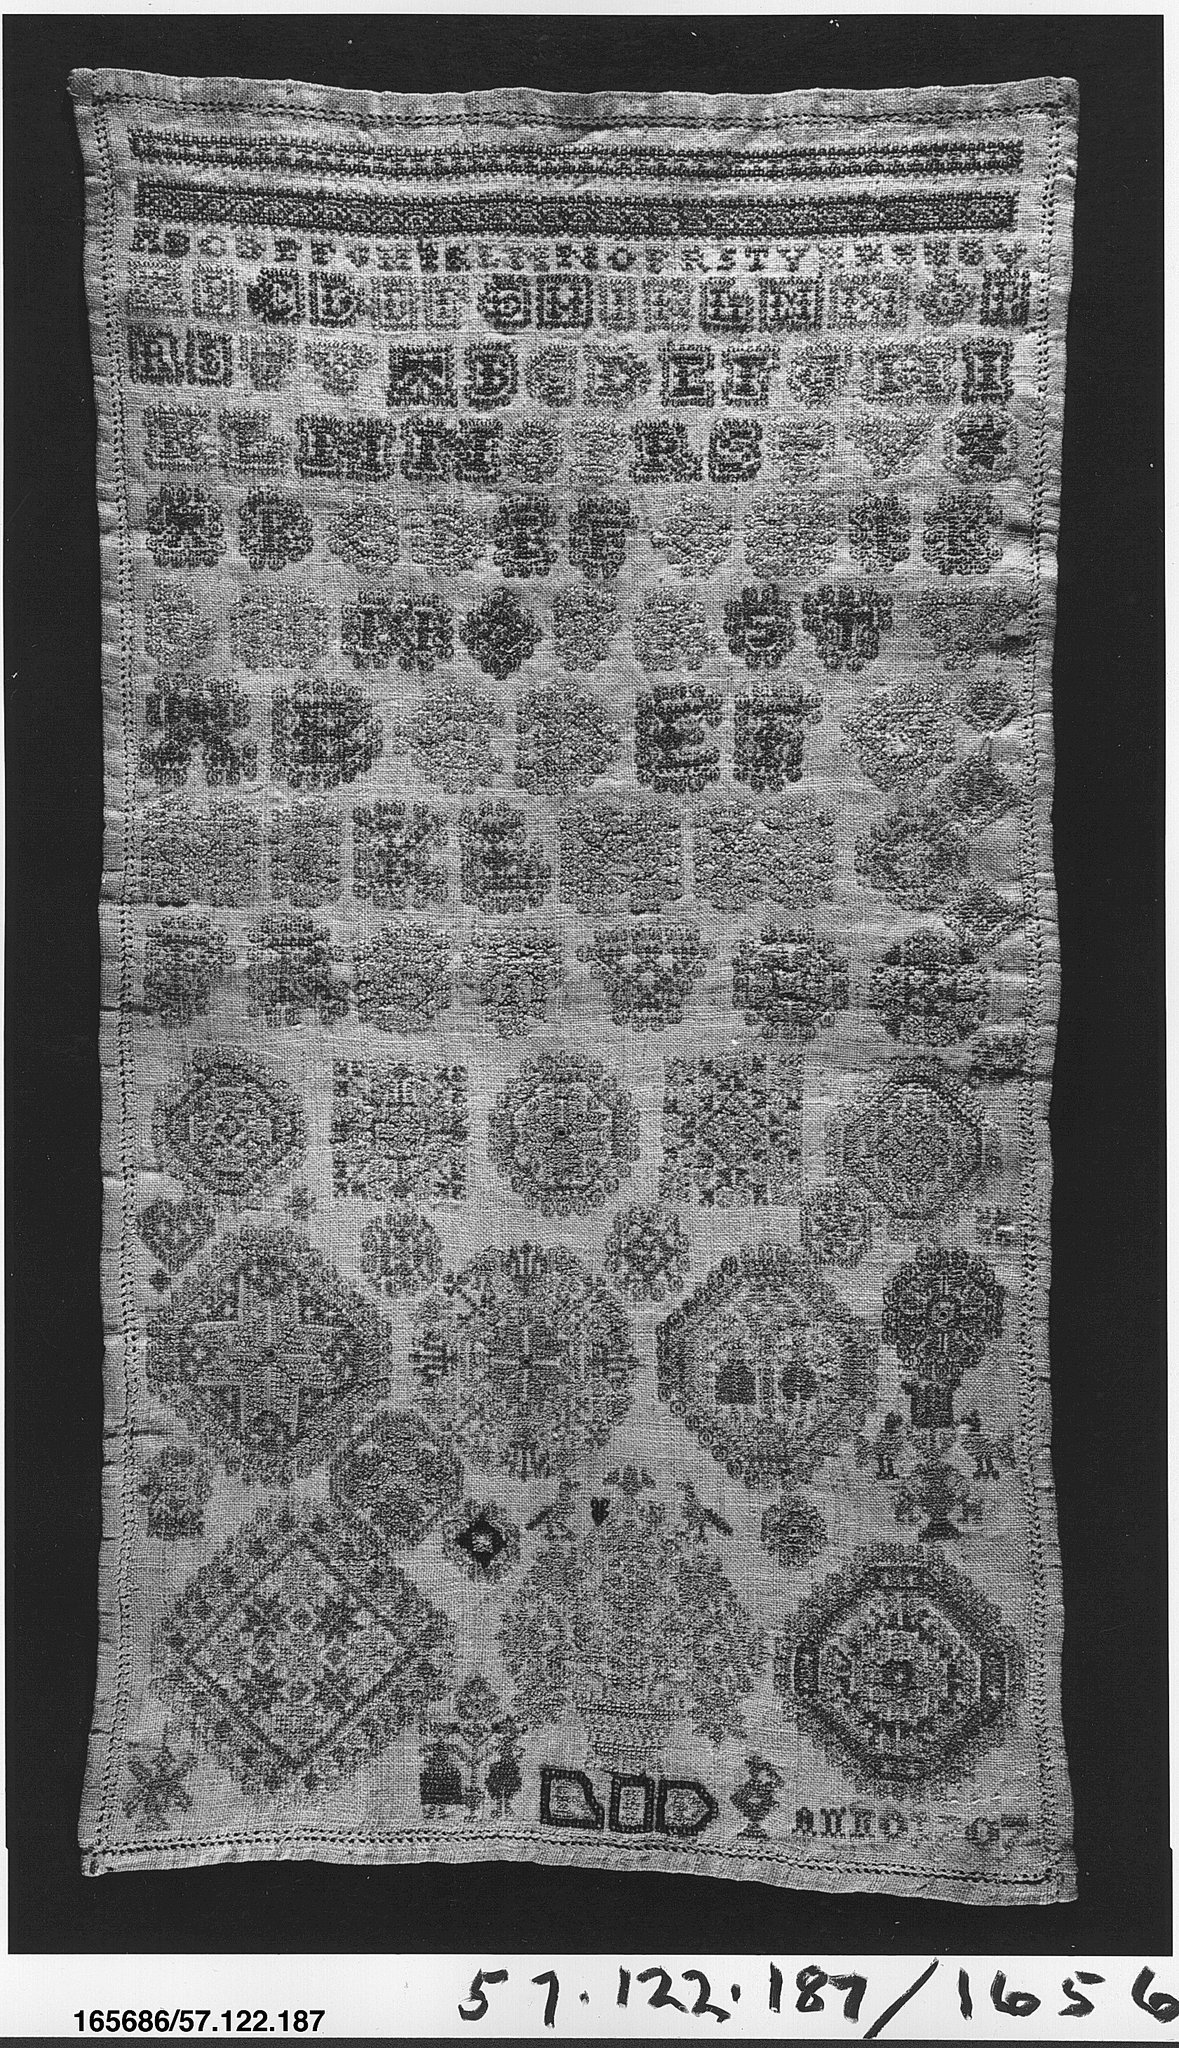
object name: sampler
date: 1707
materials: linen, silk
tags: flowers